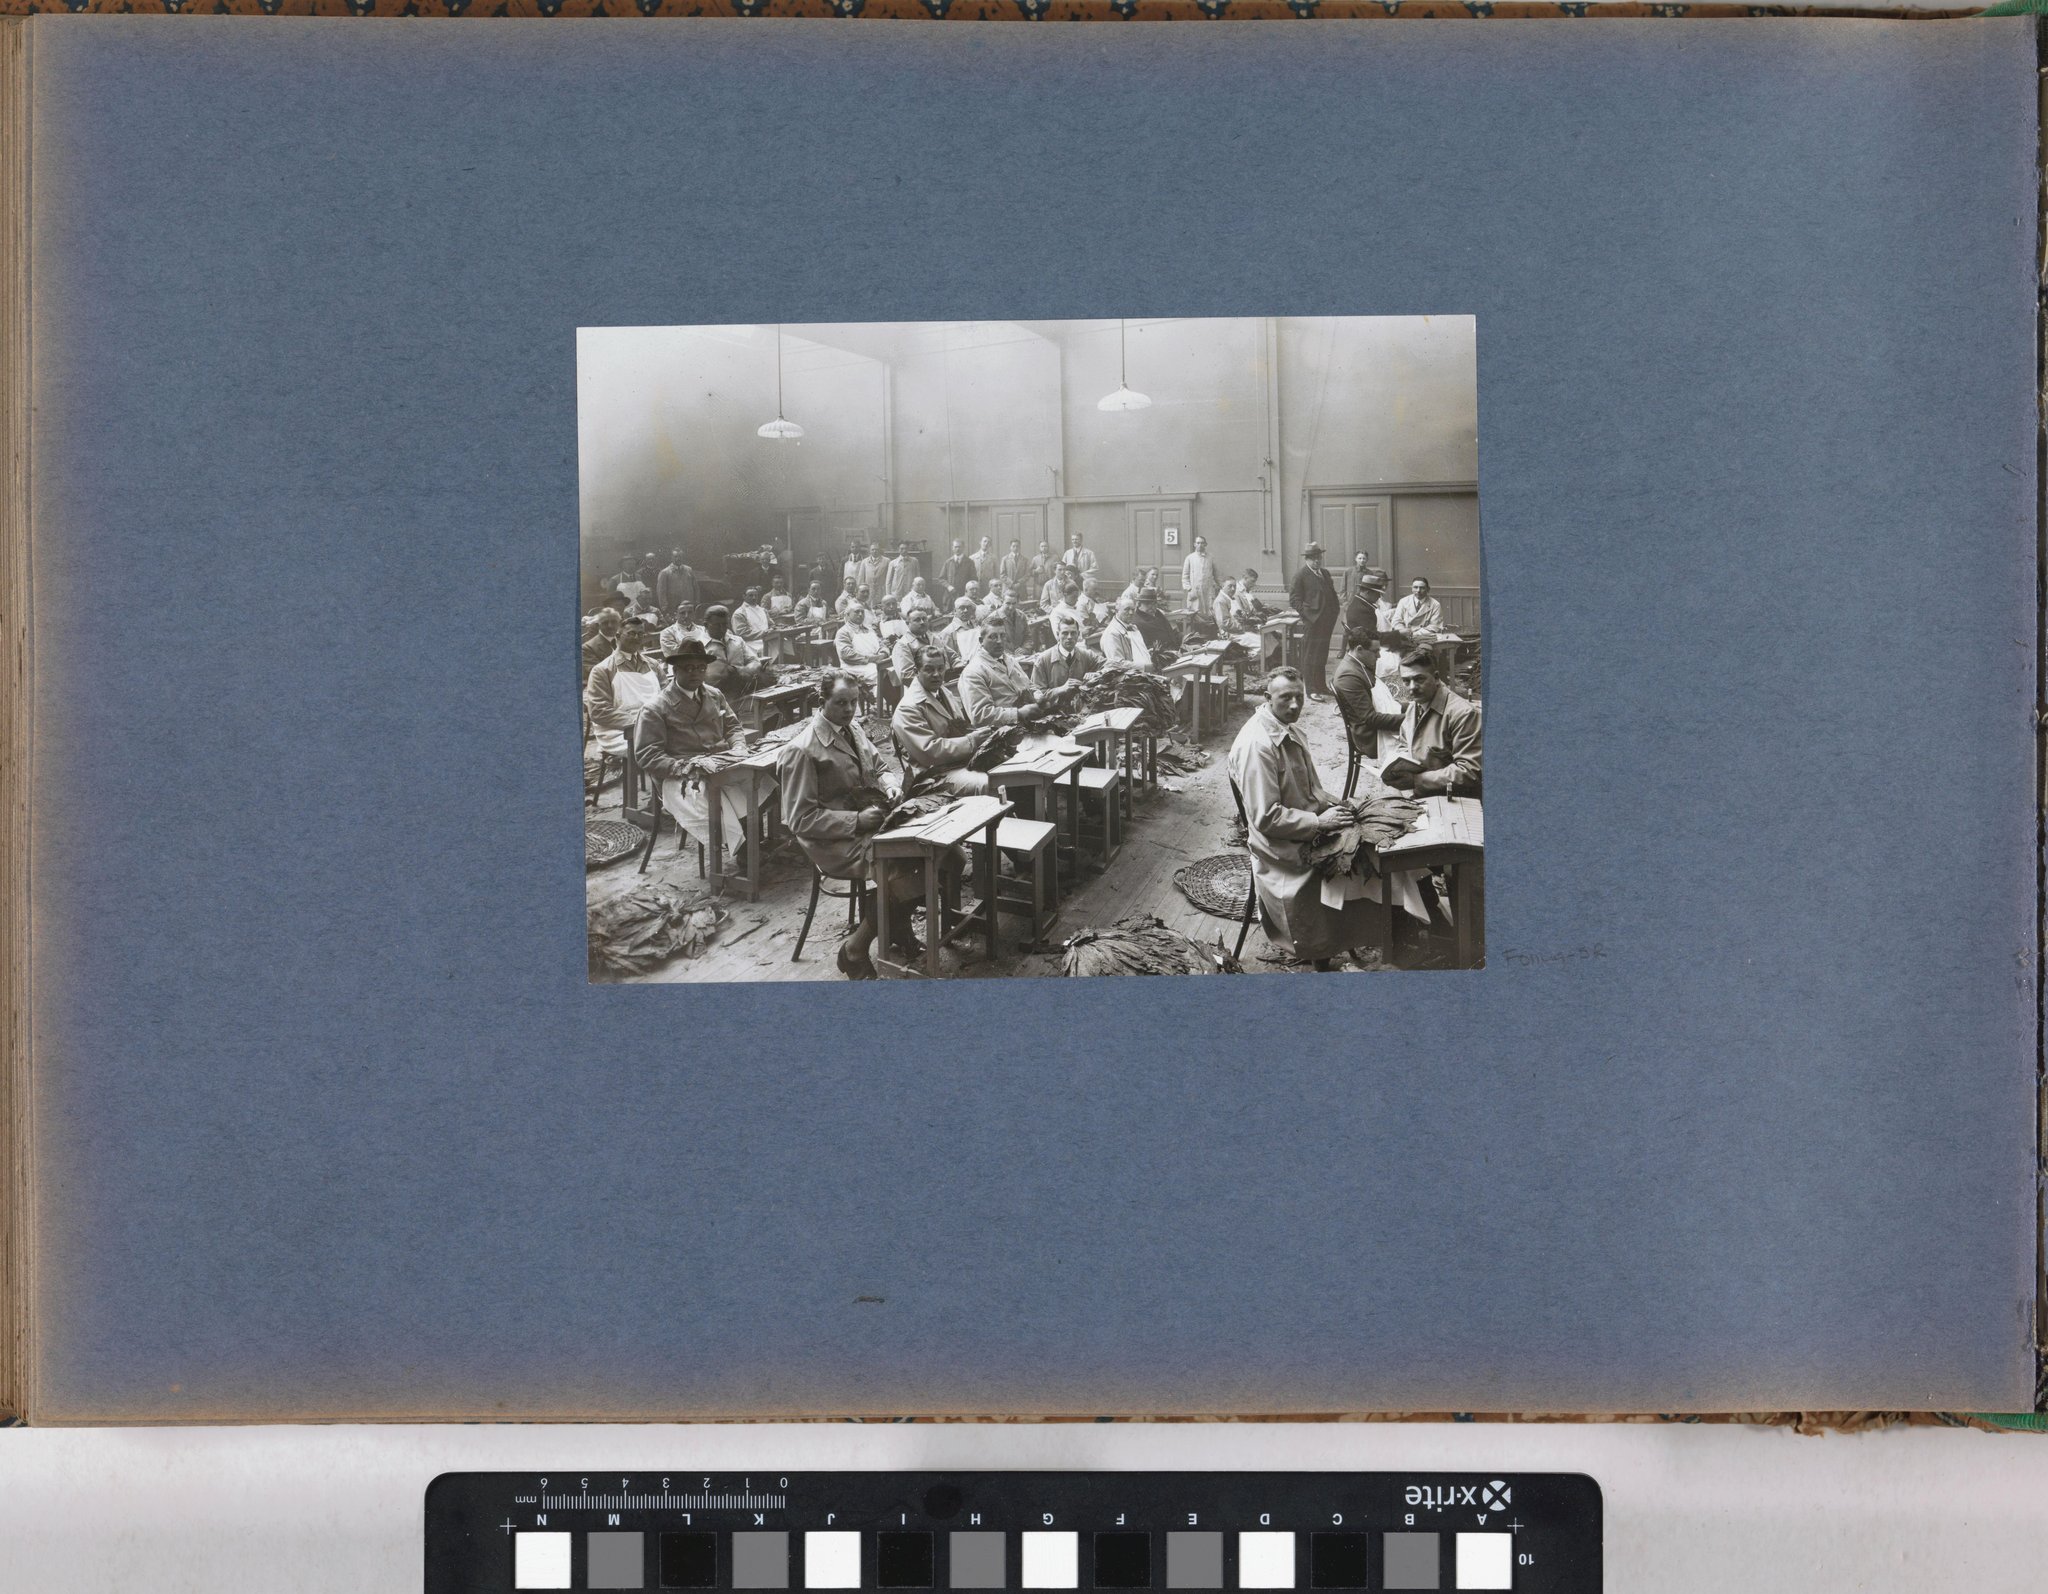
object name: album leaf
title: Mannen verwerken tabaksbladeren in een zaal, vermoedelijk in een sigarenfabriek in Nederland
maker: Anonymous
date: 1900-1920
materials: paper, photographic support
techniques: gelatin silver print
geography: netherlands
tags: cigar, workshop, tobacco, netherlands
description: Onderdeel van reisalbum met foto's van bedrijvigheid en bezienswaardigheden op Sumatra en Java en van de reis naar en van Nederlands-Indië.